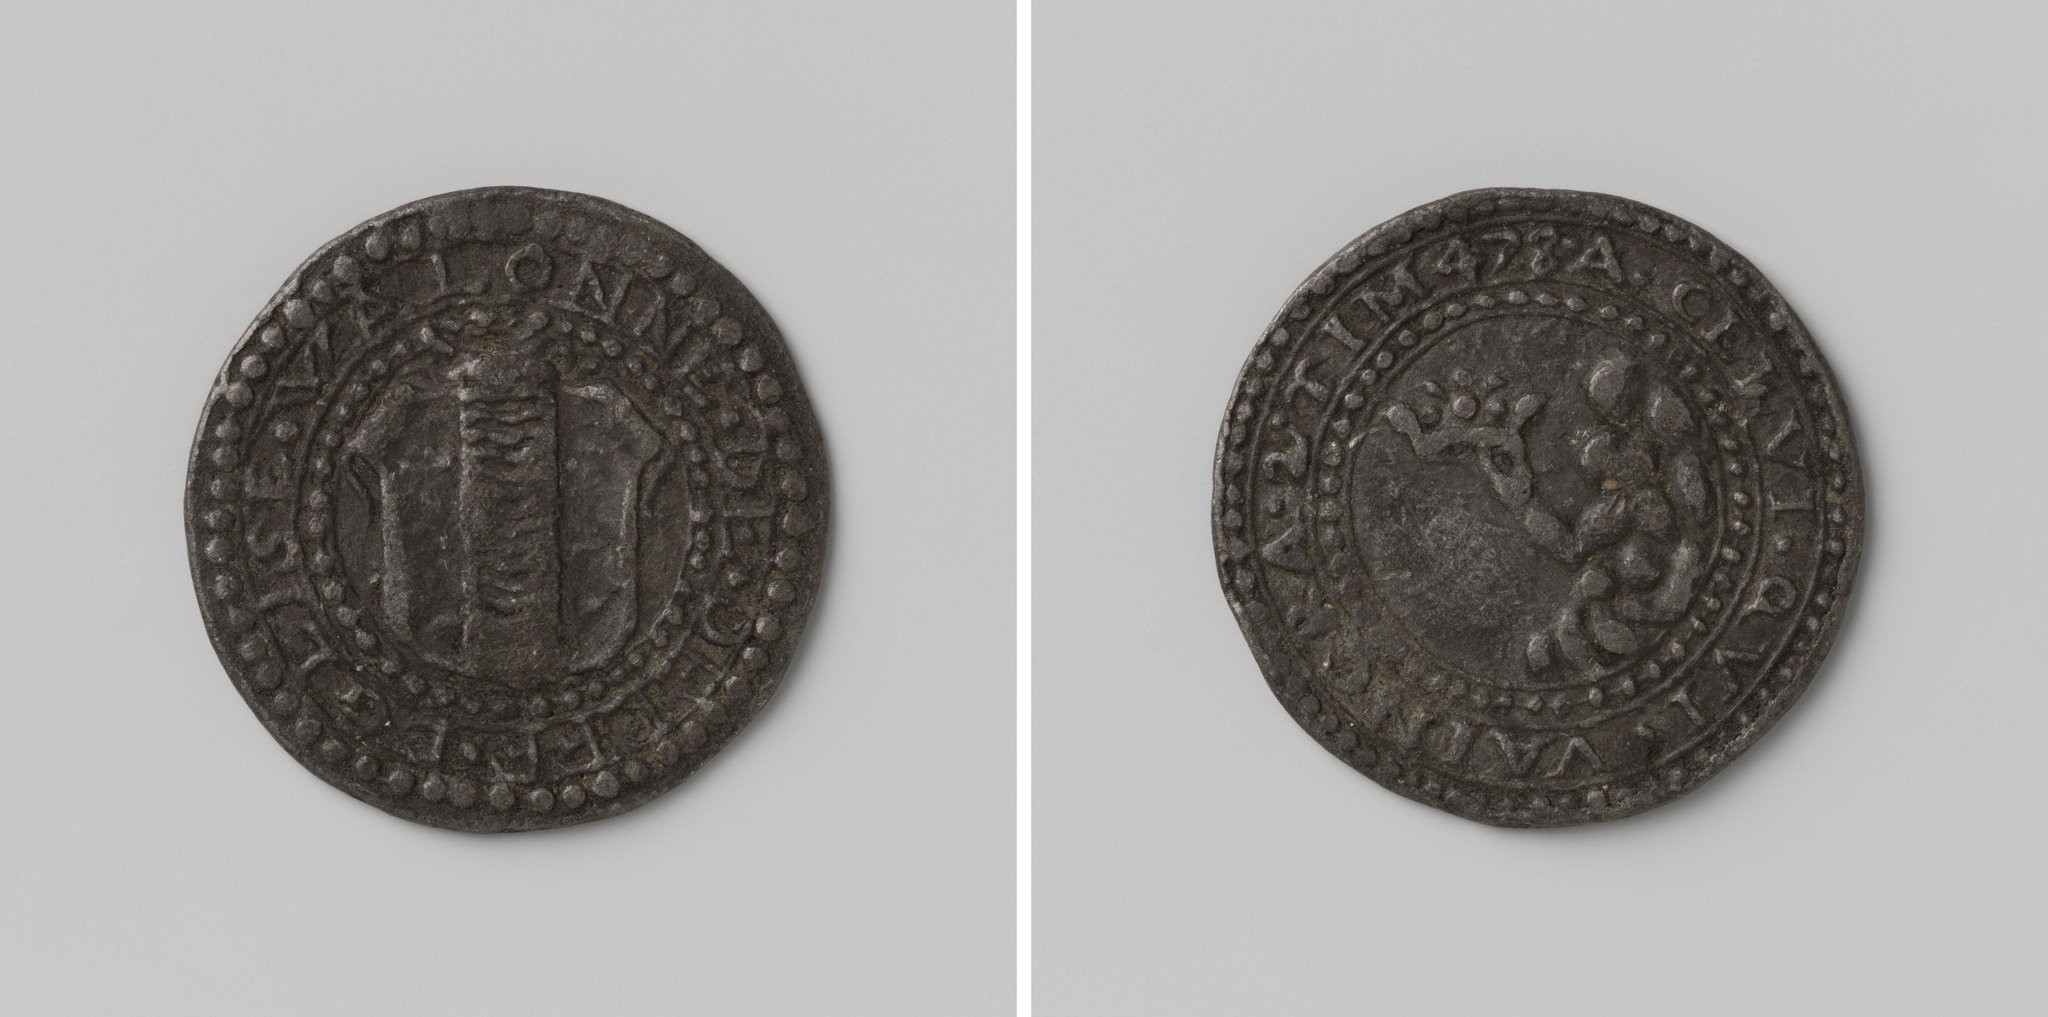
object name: armenloodje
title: Waalse kerk te Delft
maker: Anonymous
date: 1585-1700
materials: lead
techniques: casting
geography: delft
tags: delft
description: Loden penning. Voorzijde: wapenschild in cartouche binnen parelrand, omschrift en parelrand. Keerzijde: arm uit wolken houdt kroon in hand binnen omschrift.